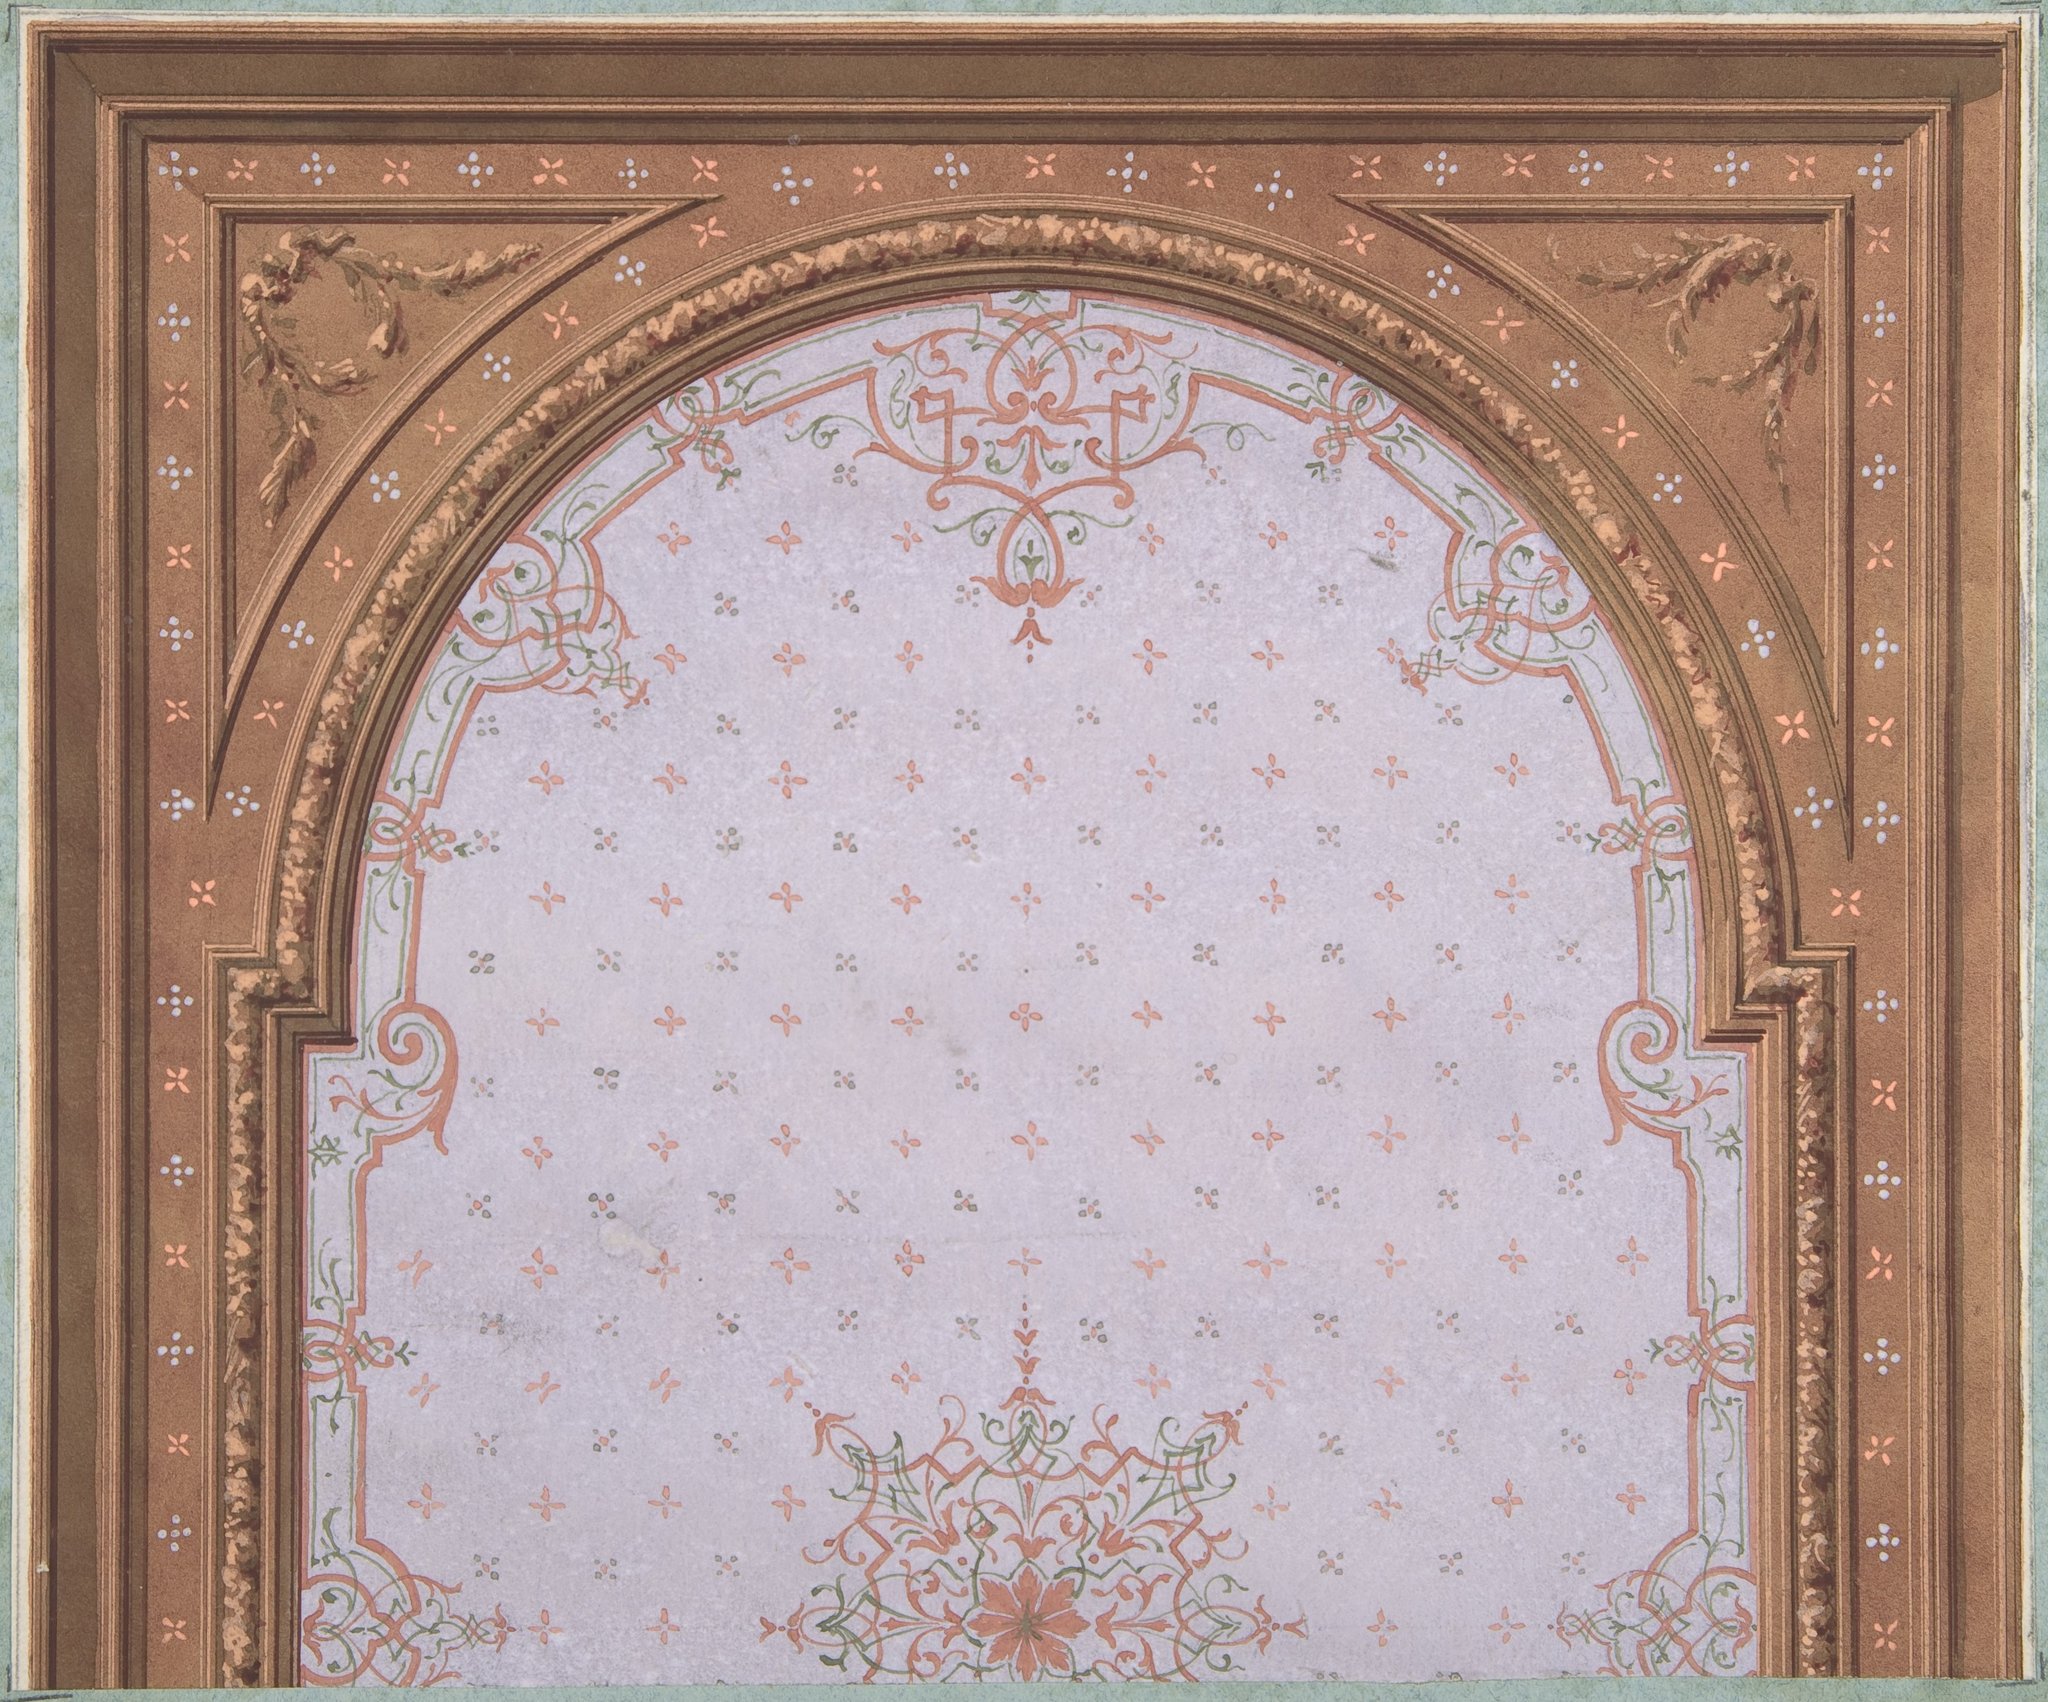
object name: drawing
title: Design for Ceiling, Hôtel Cottier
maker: jules-edmond-charles lachaise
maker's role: artist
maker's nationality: french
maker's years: 1897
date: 1879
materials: watercolor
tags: ceilings